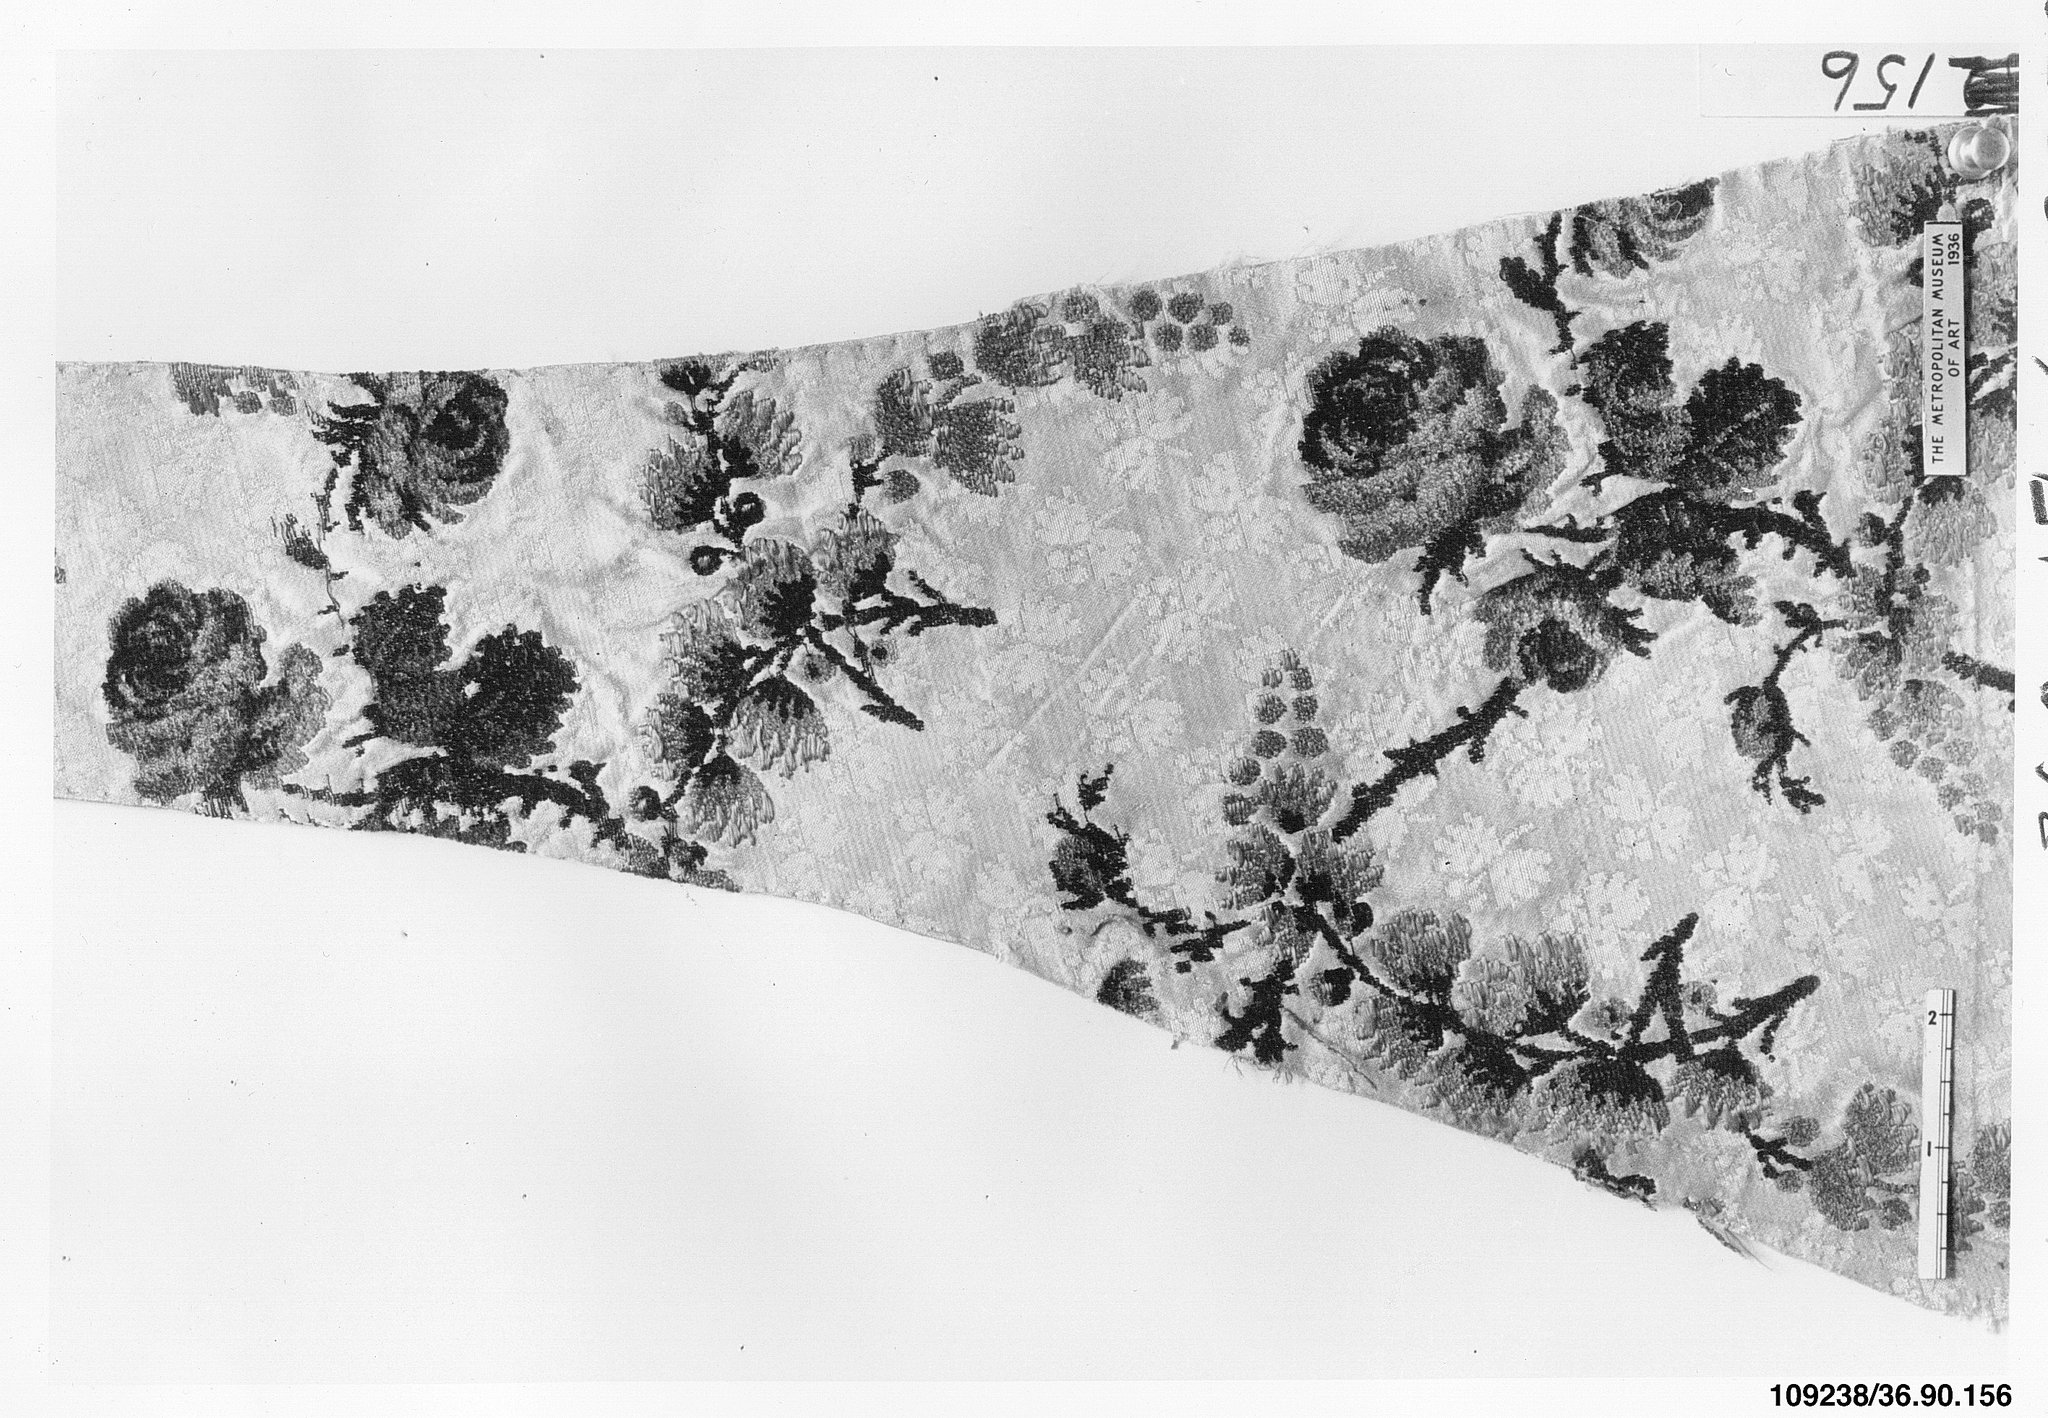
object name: piece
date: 1745-1750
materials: silk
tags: roses